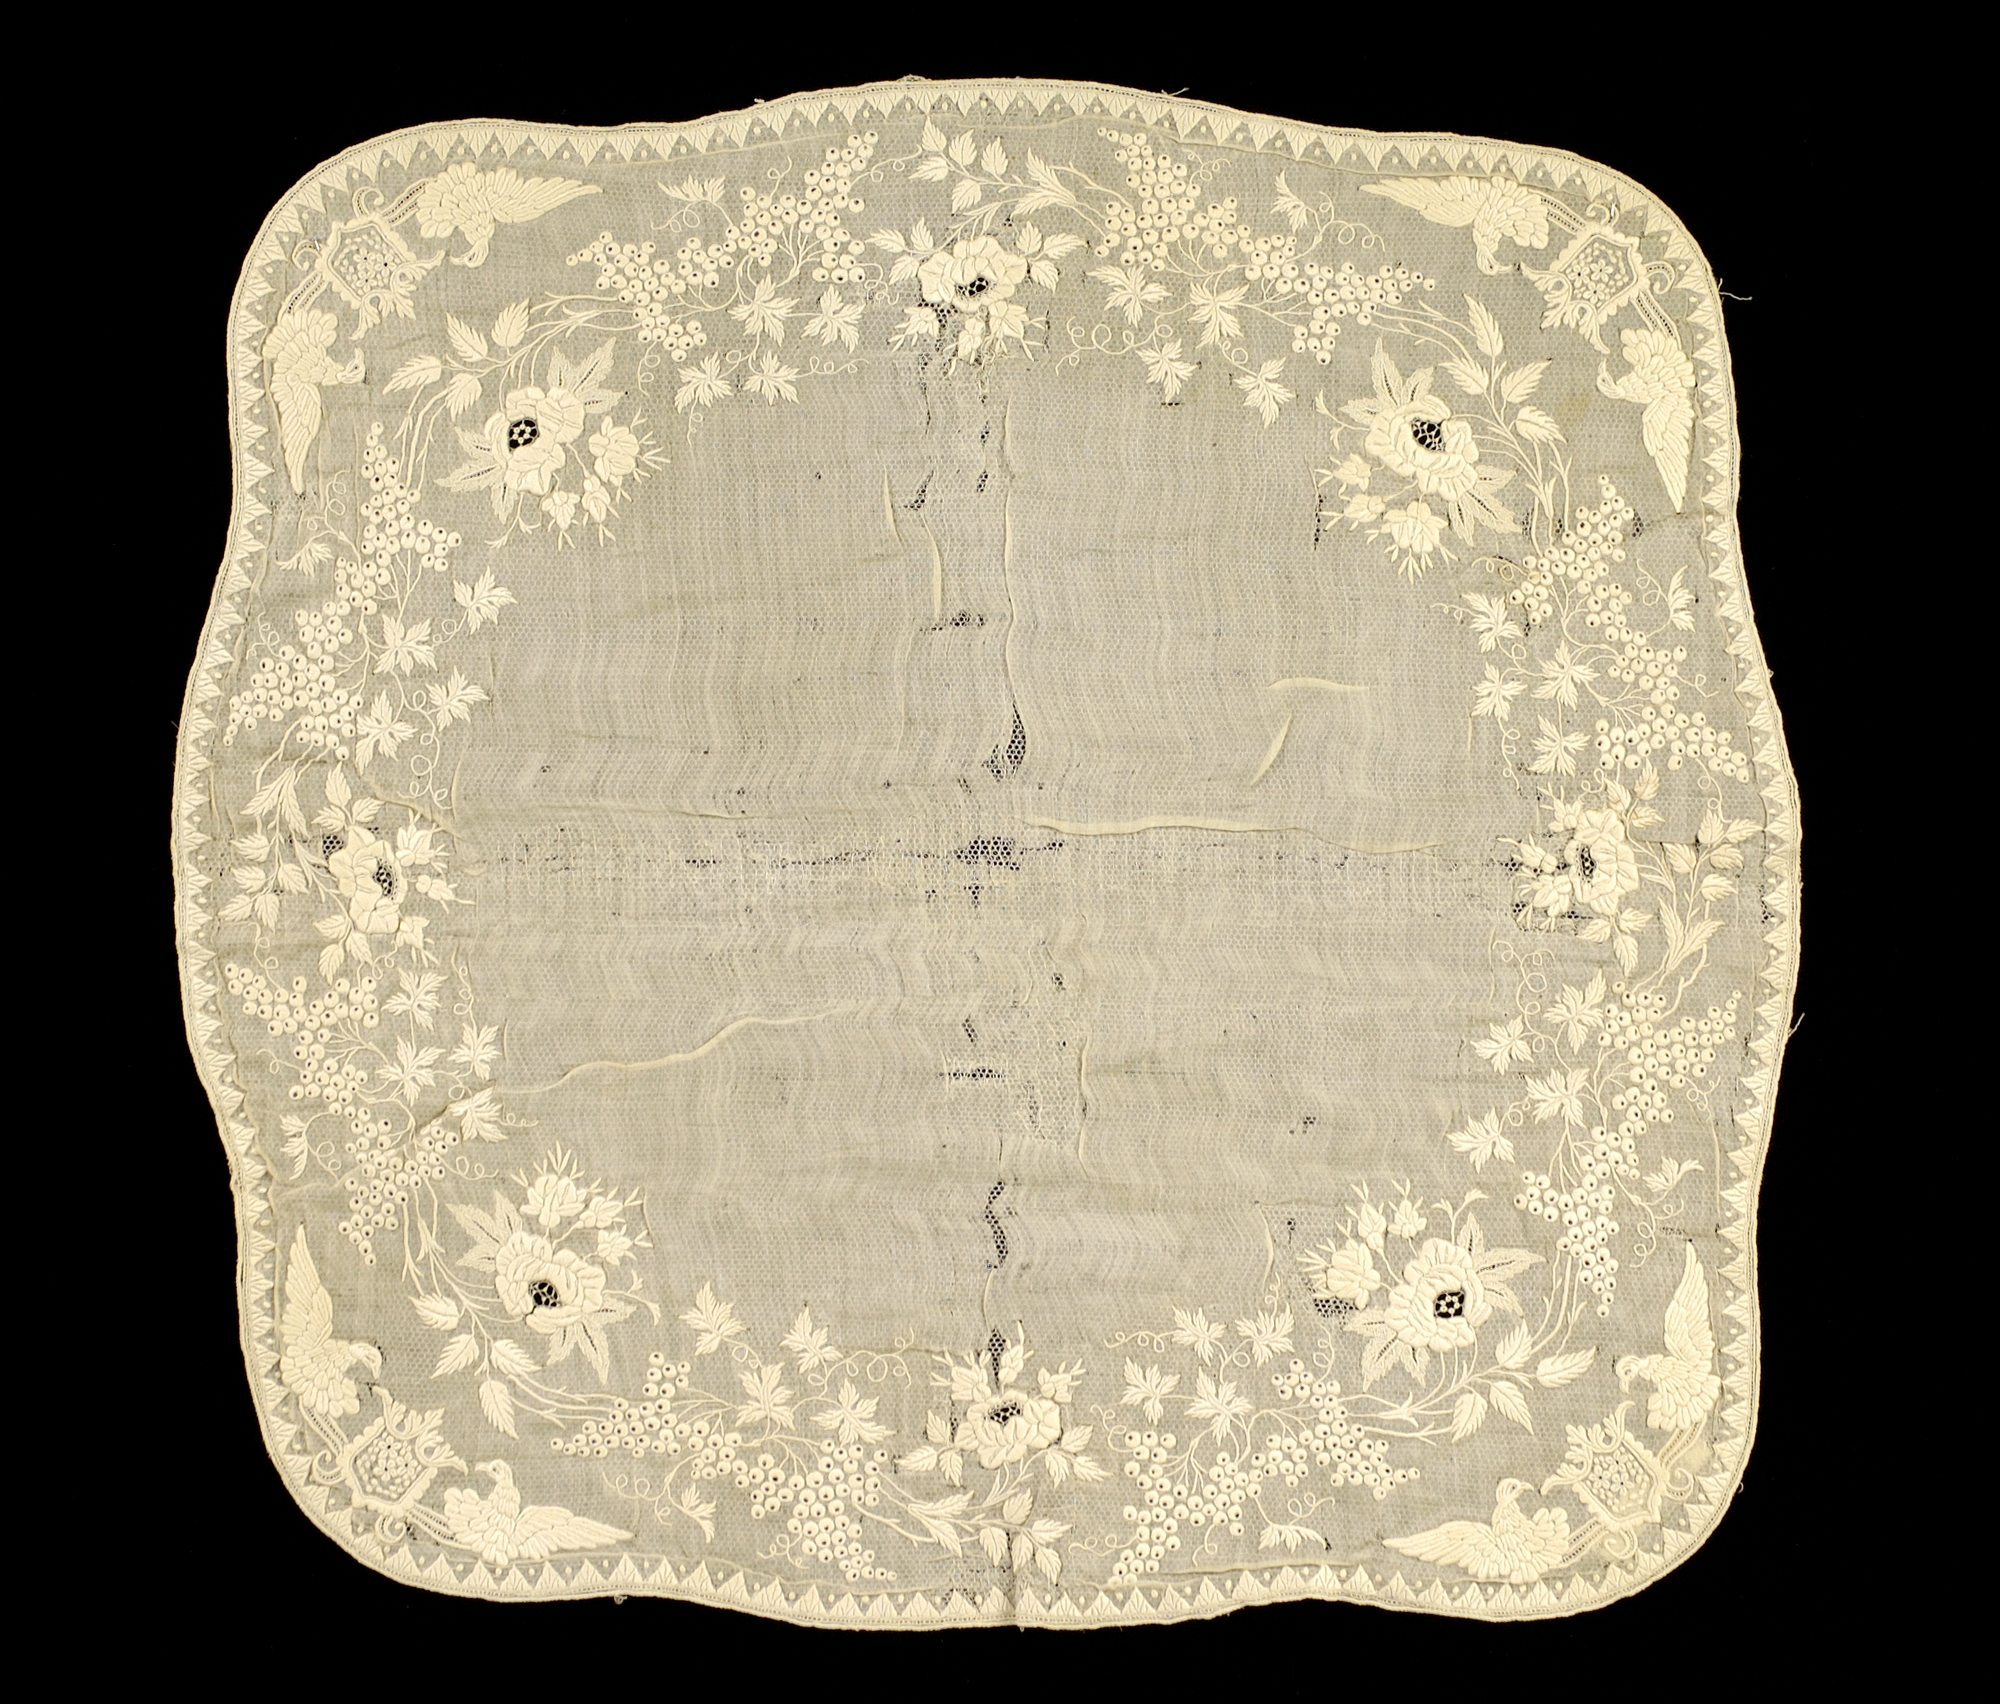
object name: handkerchief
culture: french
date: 1850-1860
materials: cotton